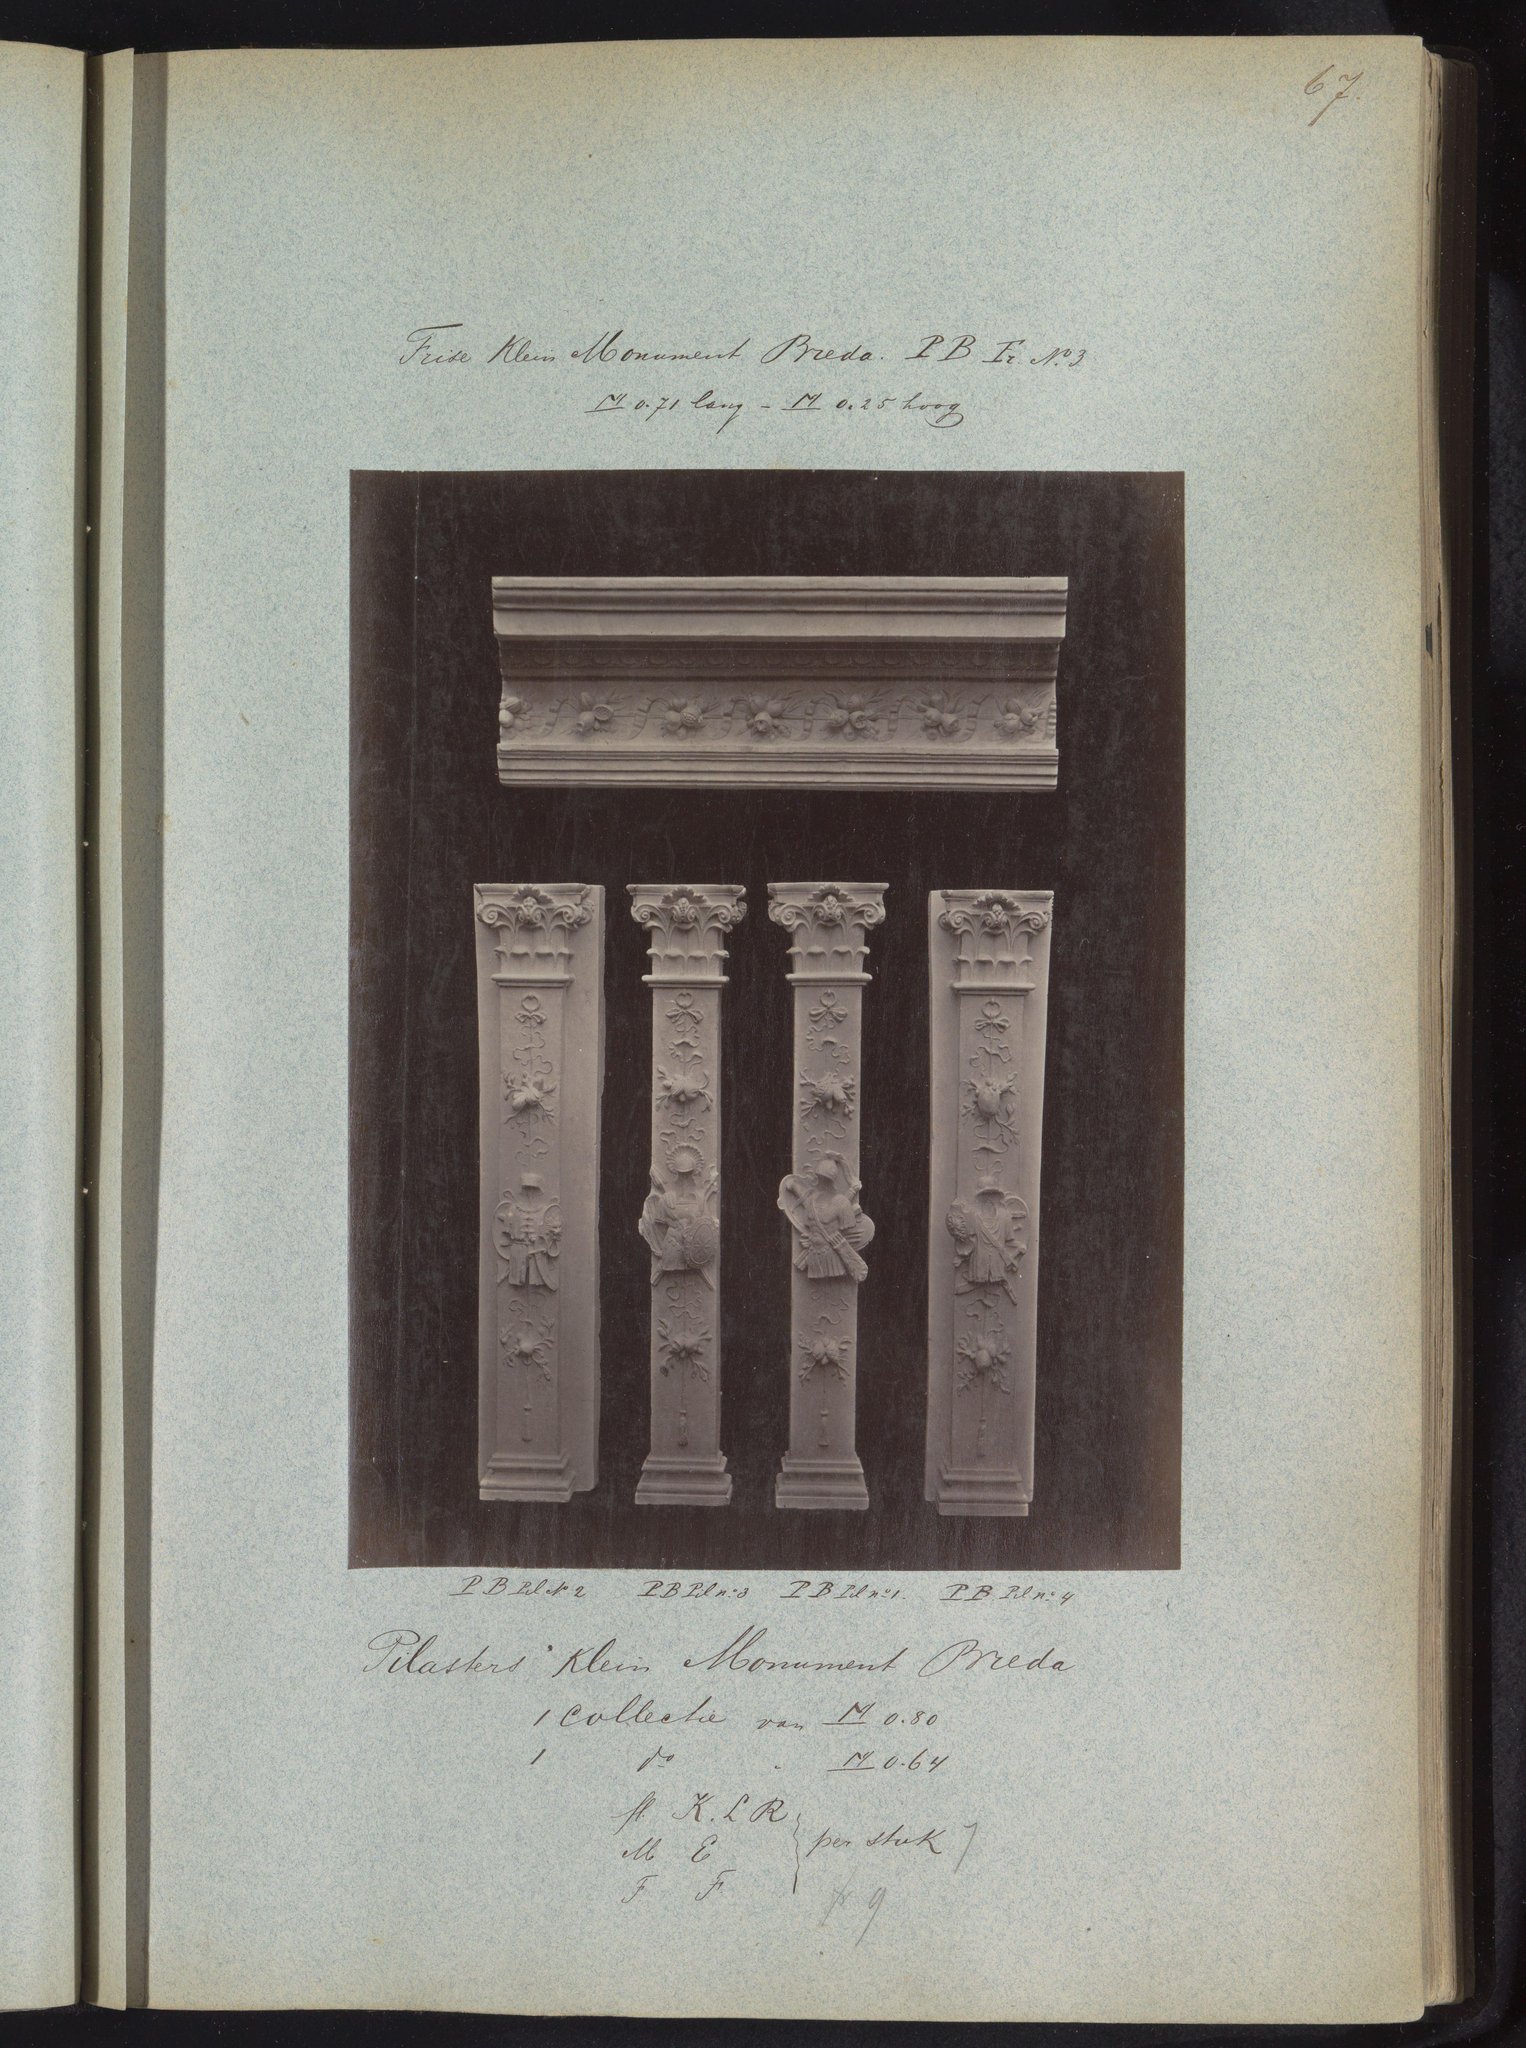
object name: photograph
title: Gipsen afgietsels van pilasters en fries van een monument te Breda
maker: Anonymous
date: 1875-1900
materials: paper, photographic support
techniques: albumen print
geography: breda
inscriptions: annotation: ‘Plasters Klein Monument Breda / 1 collectie van M 0.80’, annotation, annotation: ‘Fries Klein Monument Breda / M 0.71 lang -M 0.25 hoog’